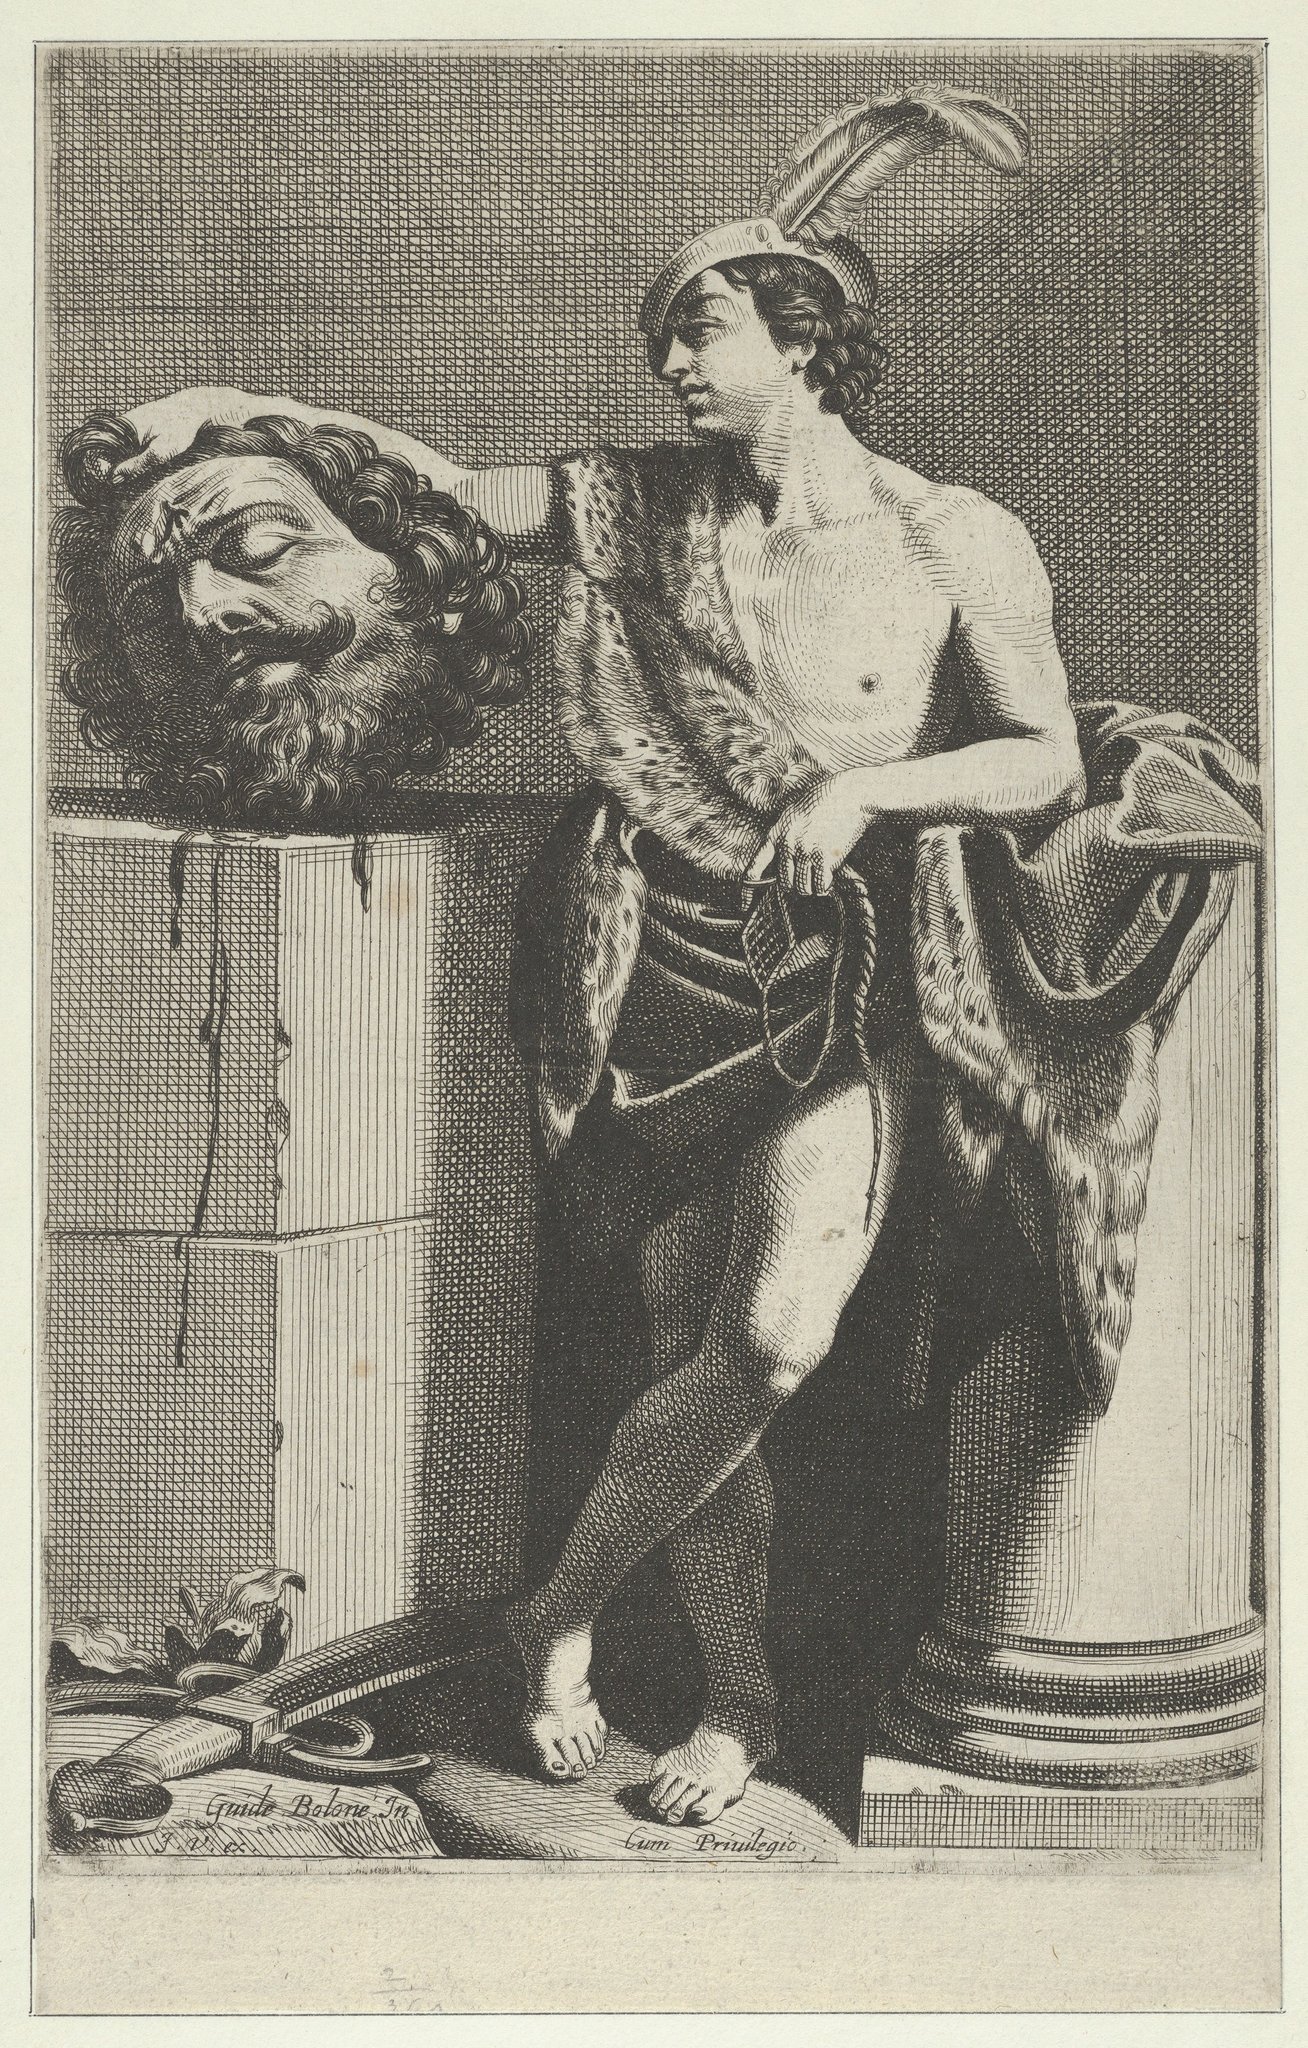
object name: print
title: David standing with crossed legs and holding the head of Goliath on a pedestal at left, a sword on the ground, after Reni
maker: Anonymous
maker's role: artist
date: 1600-1700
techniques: etching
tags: swords,heads,david